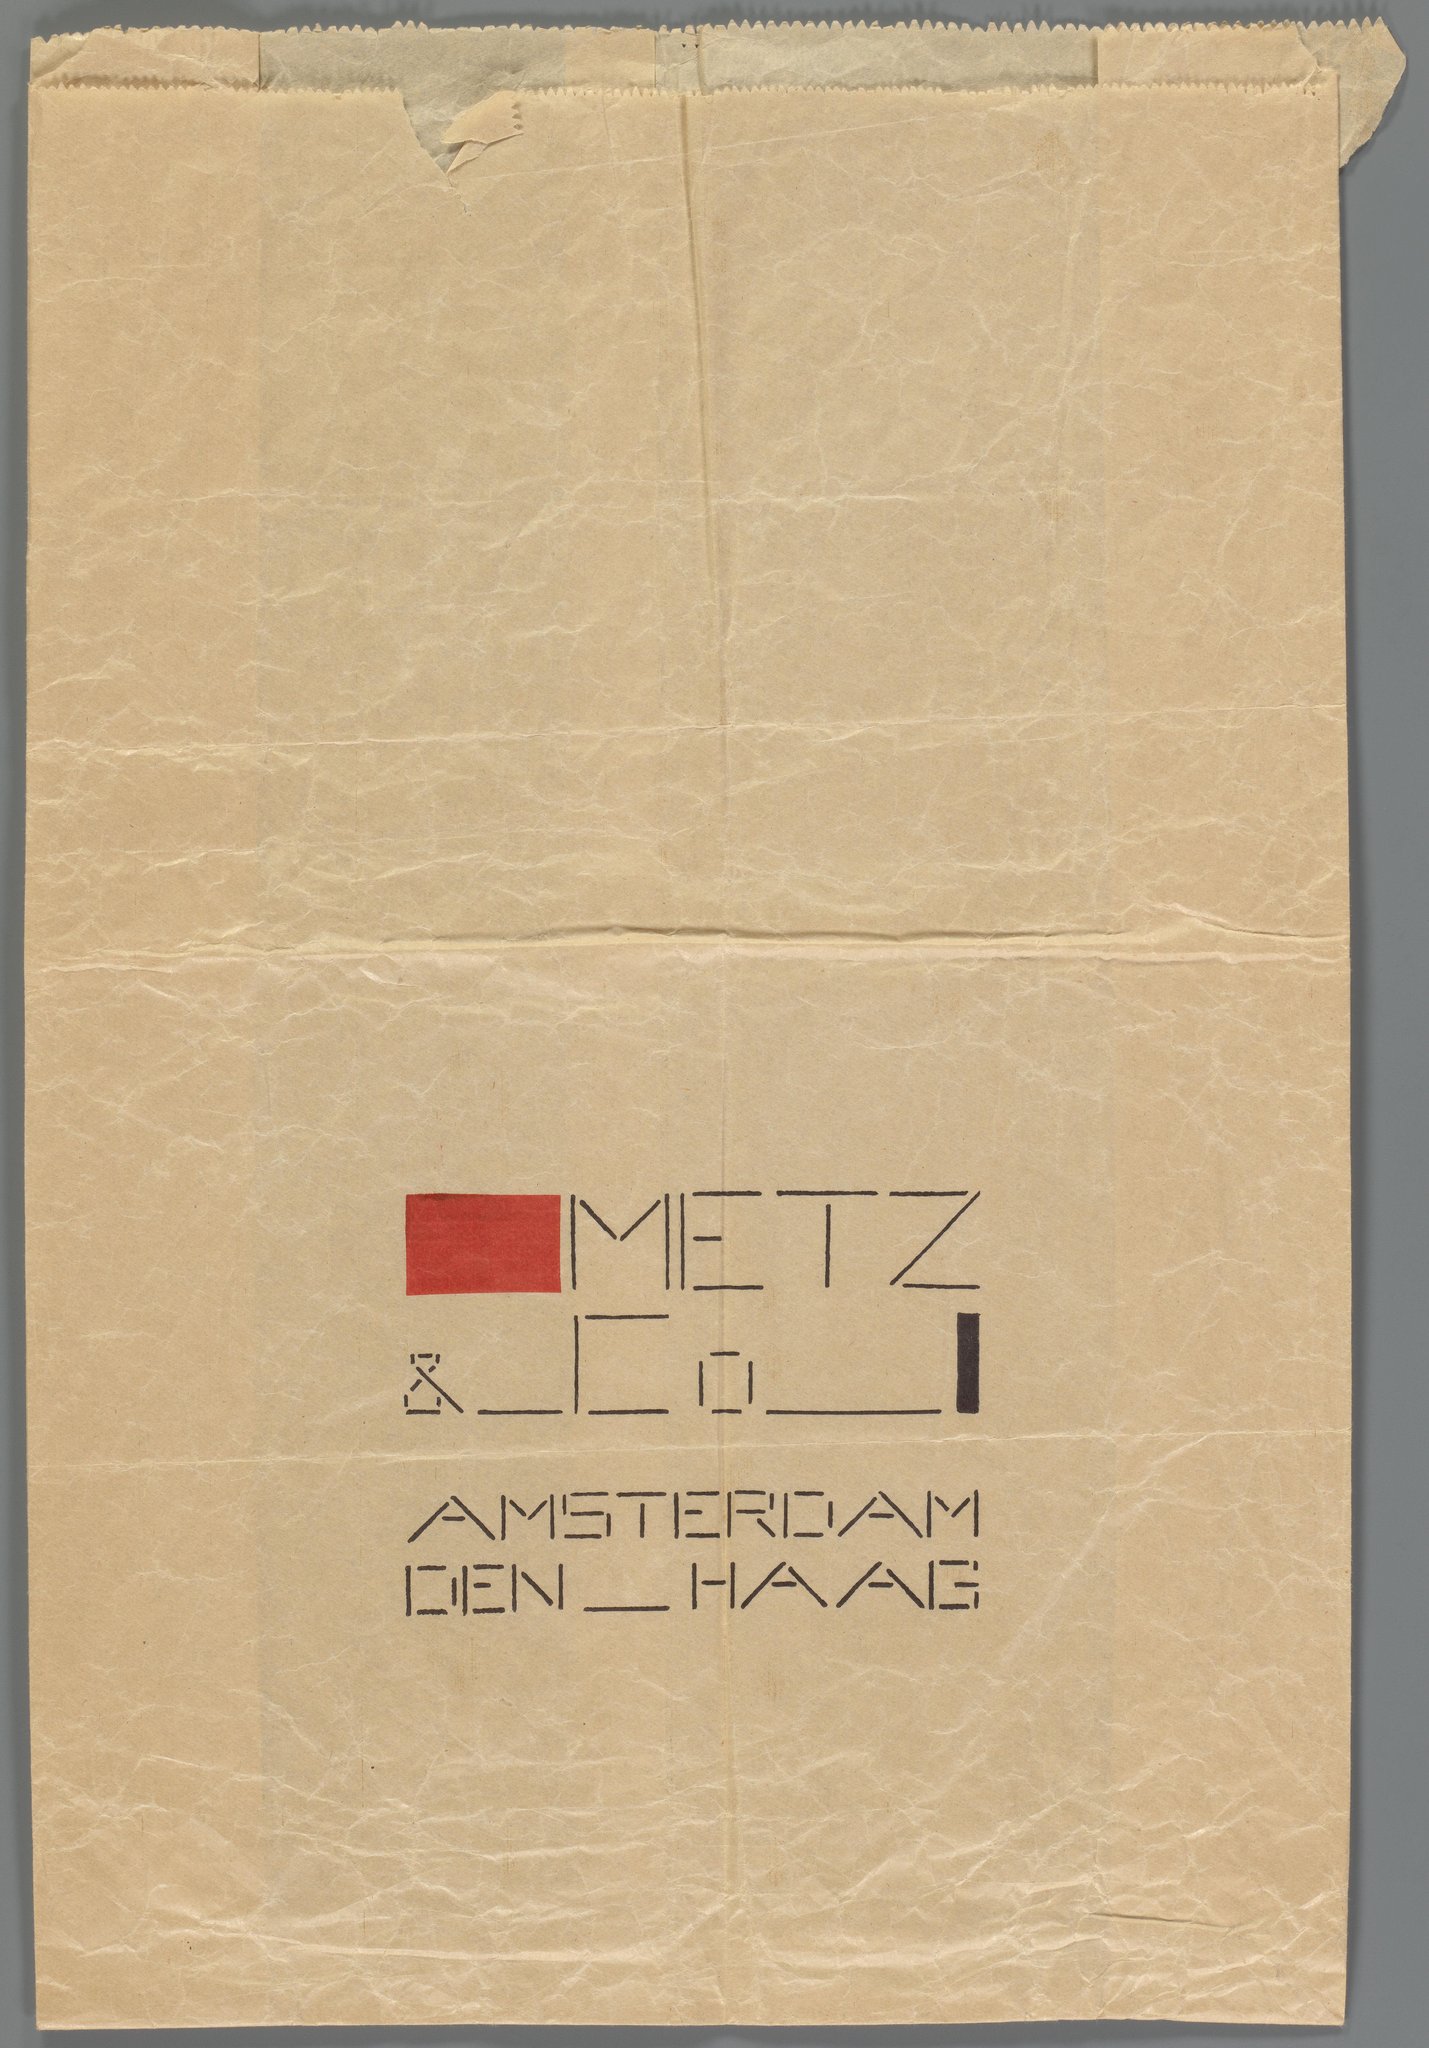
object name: advertisement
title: Papieren zak voor Metz & Co.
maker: bart antony van der leck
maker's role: draughtsman, painter, print maker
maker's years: 1876-1958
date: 1952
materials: paper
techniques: lithograph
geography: netherlands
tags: shop, store, advertising, the hague, amsterdam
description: Papieren zak met op de voorzijde het logo van de winkels Metz & Co. in Amsterdam en Den Haag.